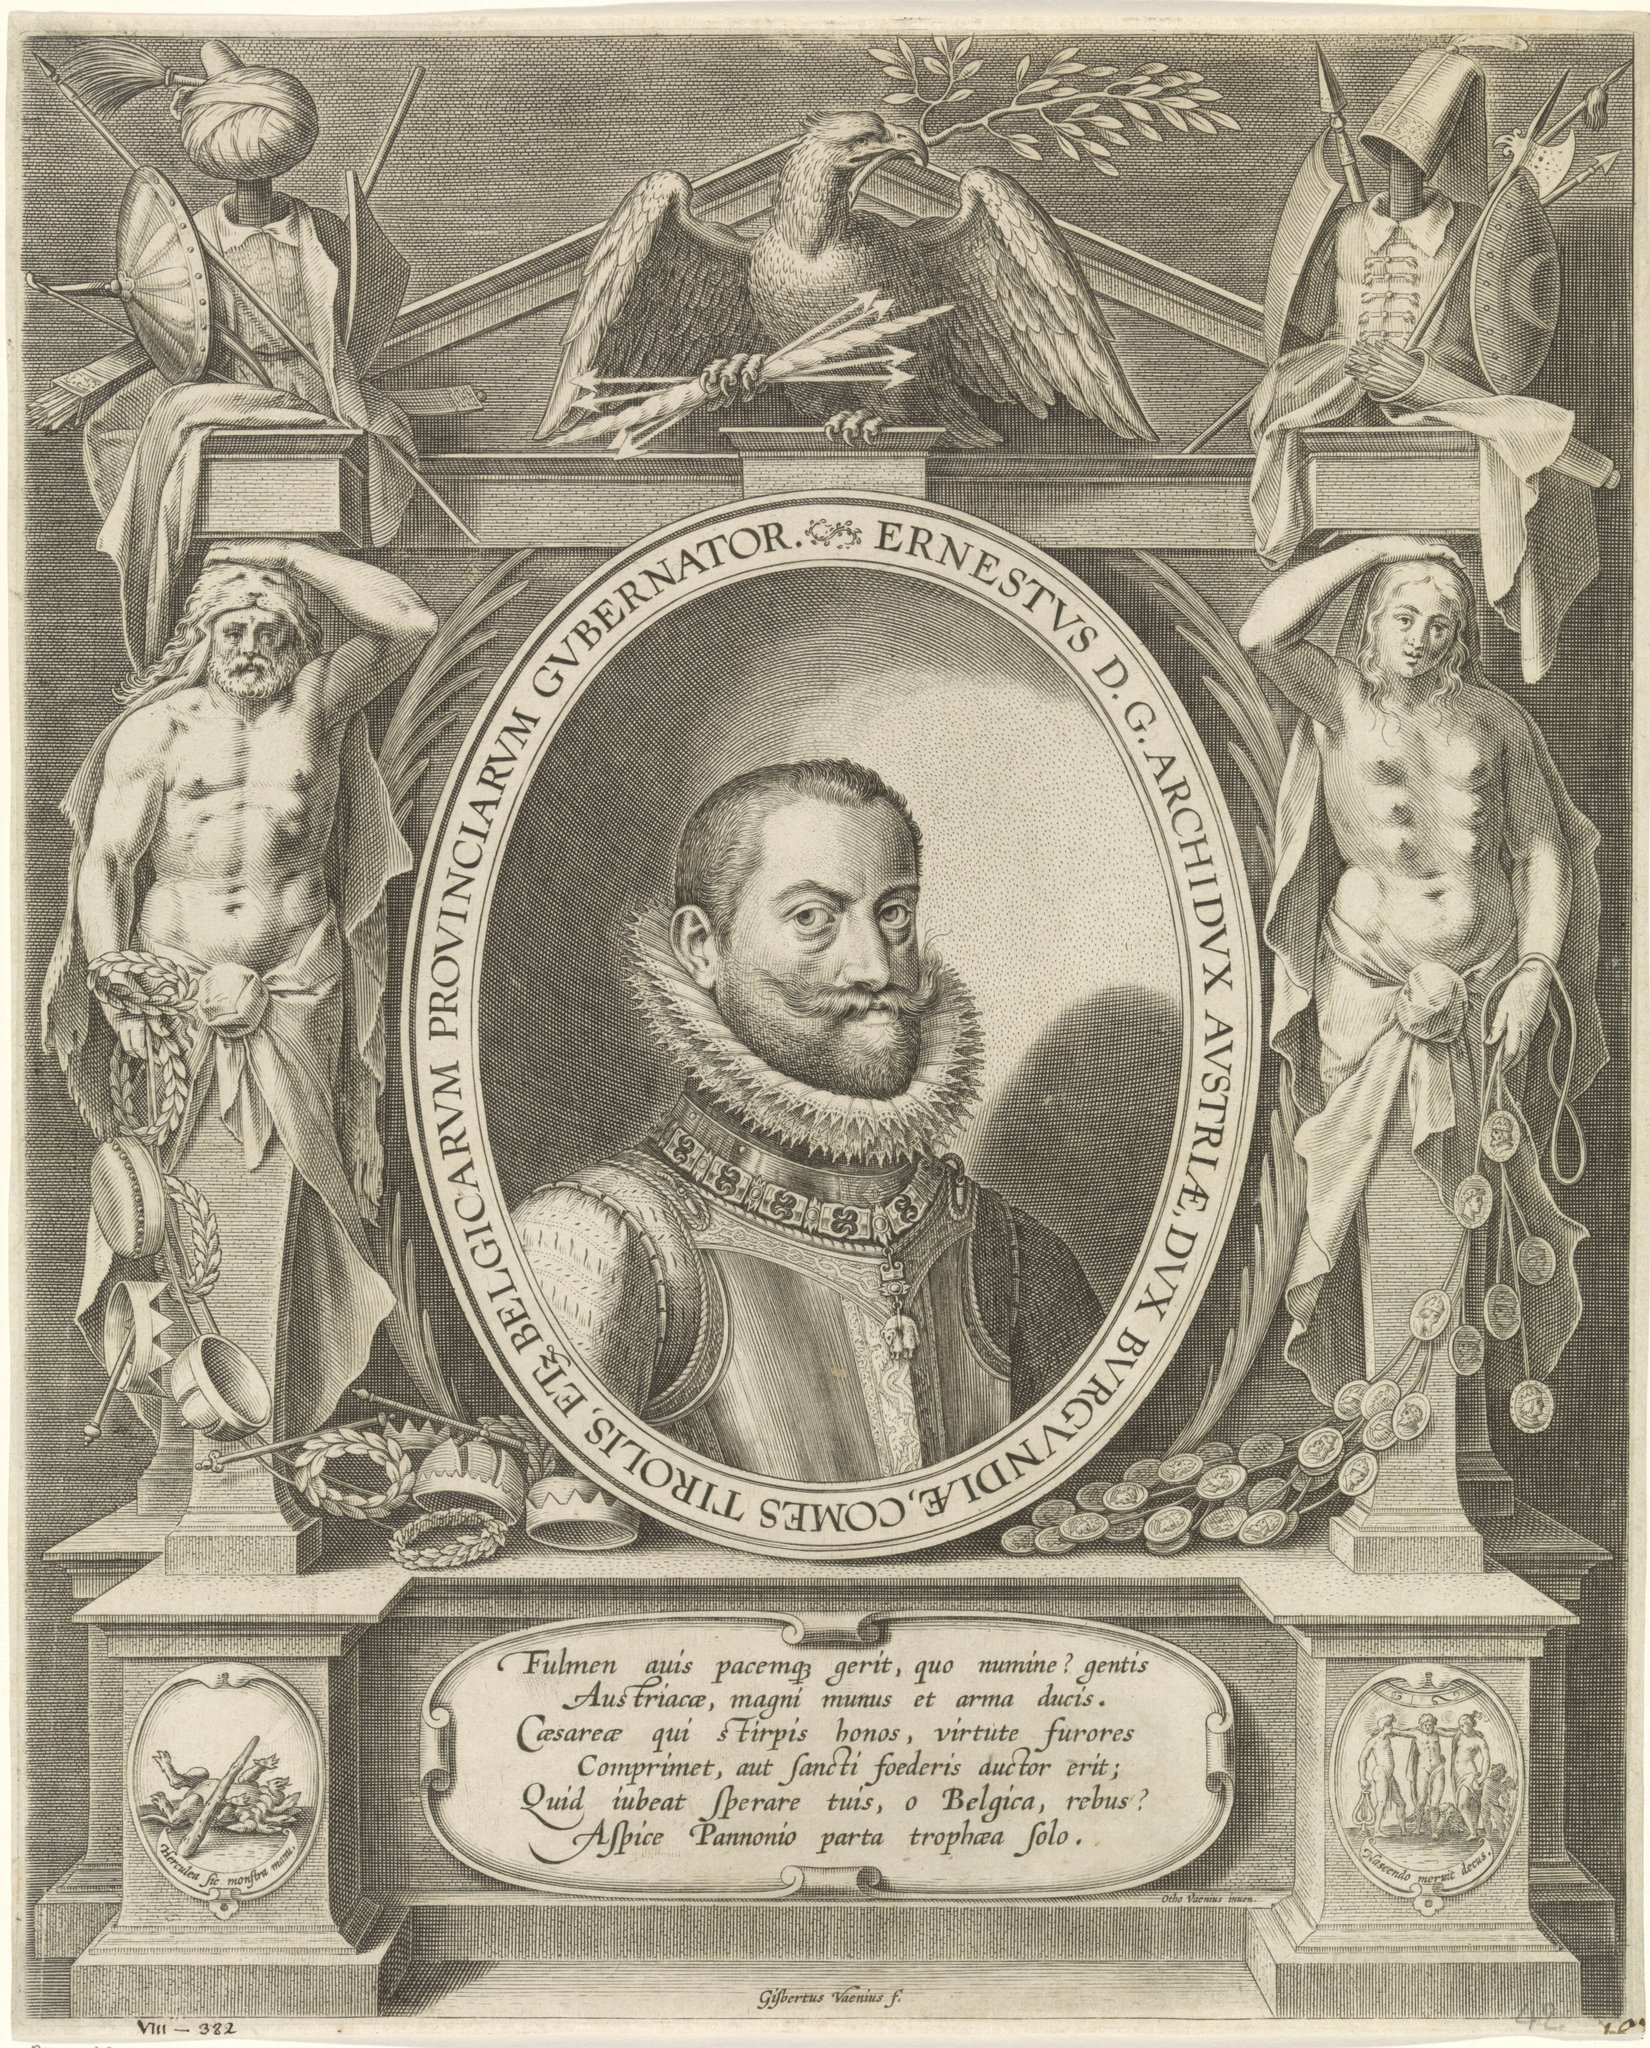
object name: print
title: Portret van Ernst, aartshertog van Oostenrijk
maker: otto van veen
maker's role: draughtsman, painter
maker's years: 1556-1629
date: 1572-1628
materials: paper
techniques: engraving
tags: vienna, brussels, 'natura' (allegorical figure or scene; or as diana of ephesus, with many breasts); 'natura' (ripa), (story of) hercules (heracles), attributes of jupiter: eagle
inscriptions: number: ‘VIII-382’, collector's mark: Lugt 964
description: Ernst aartshertog van Oostenrijk, gekleed in harnas met de orde van het Gulden Vlies: buste naar rechts in ovaal. Het ovaal is gevat in een architecturale omlijsting met Hercules (links) en Natuur (rechts) en Jupiter als adelaar middenboven.